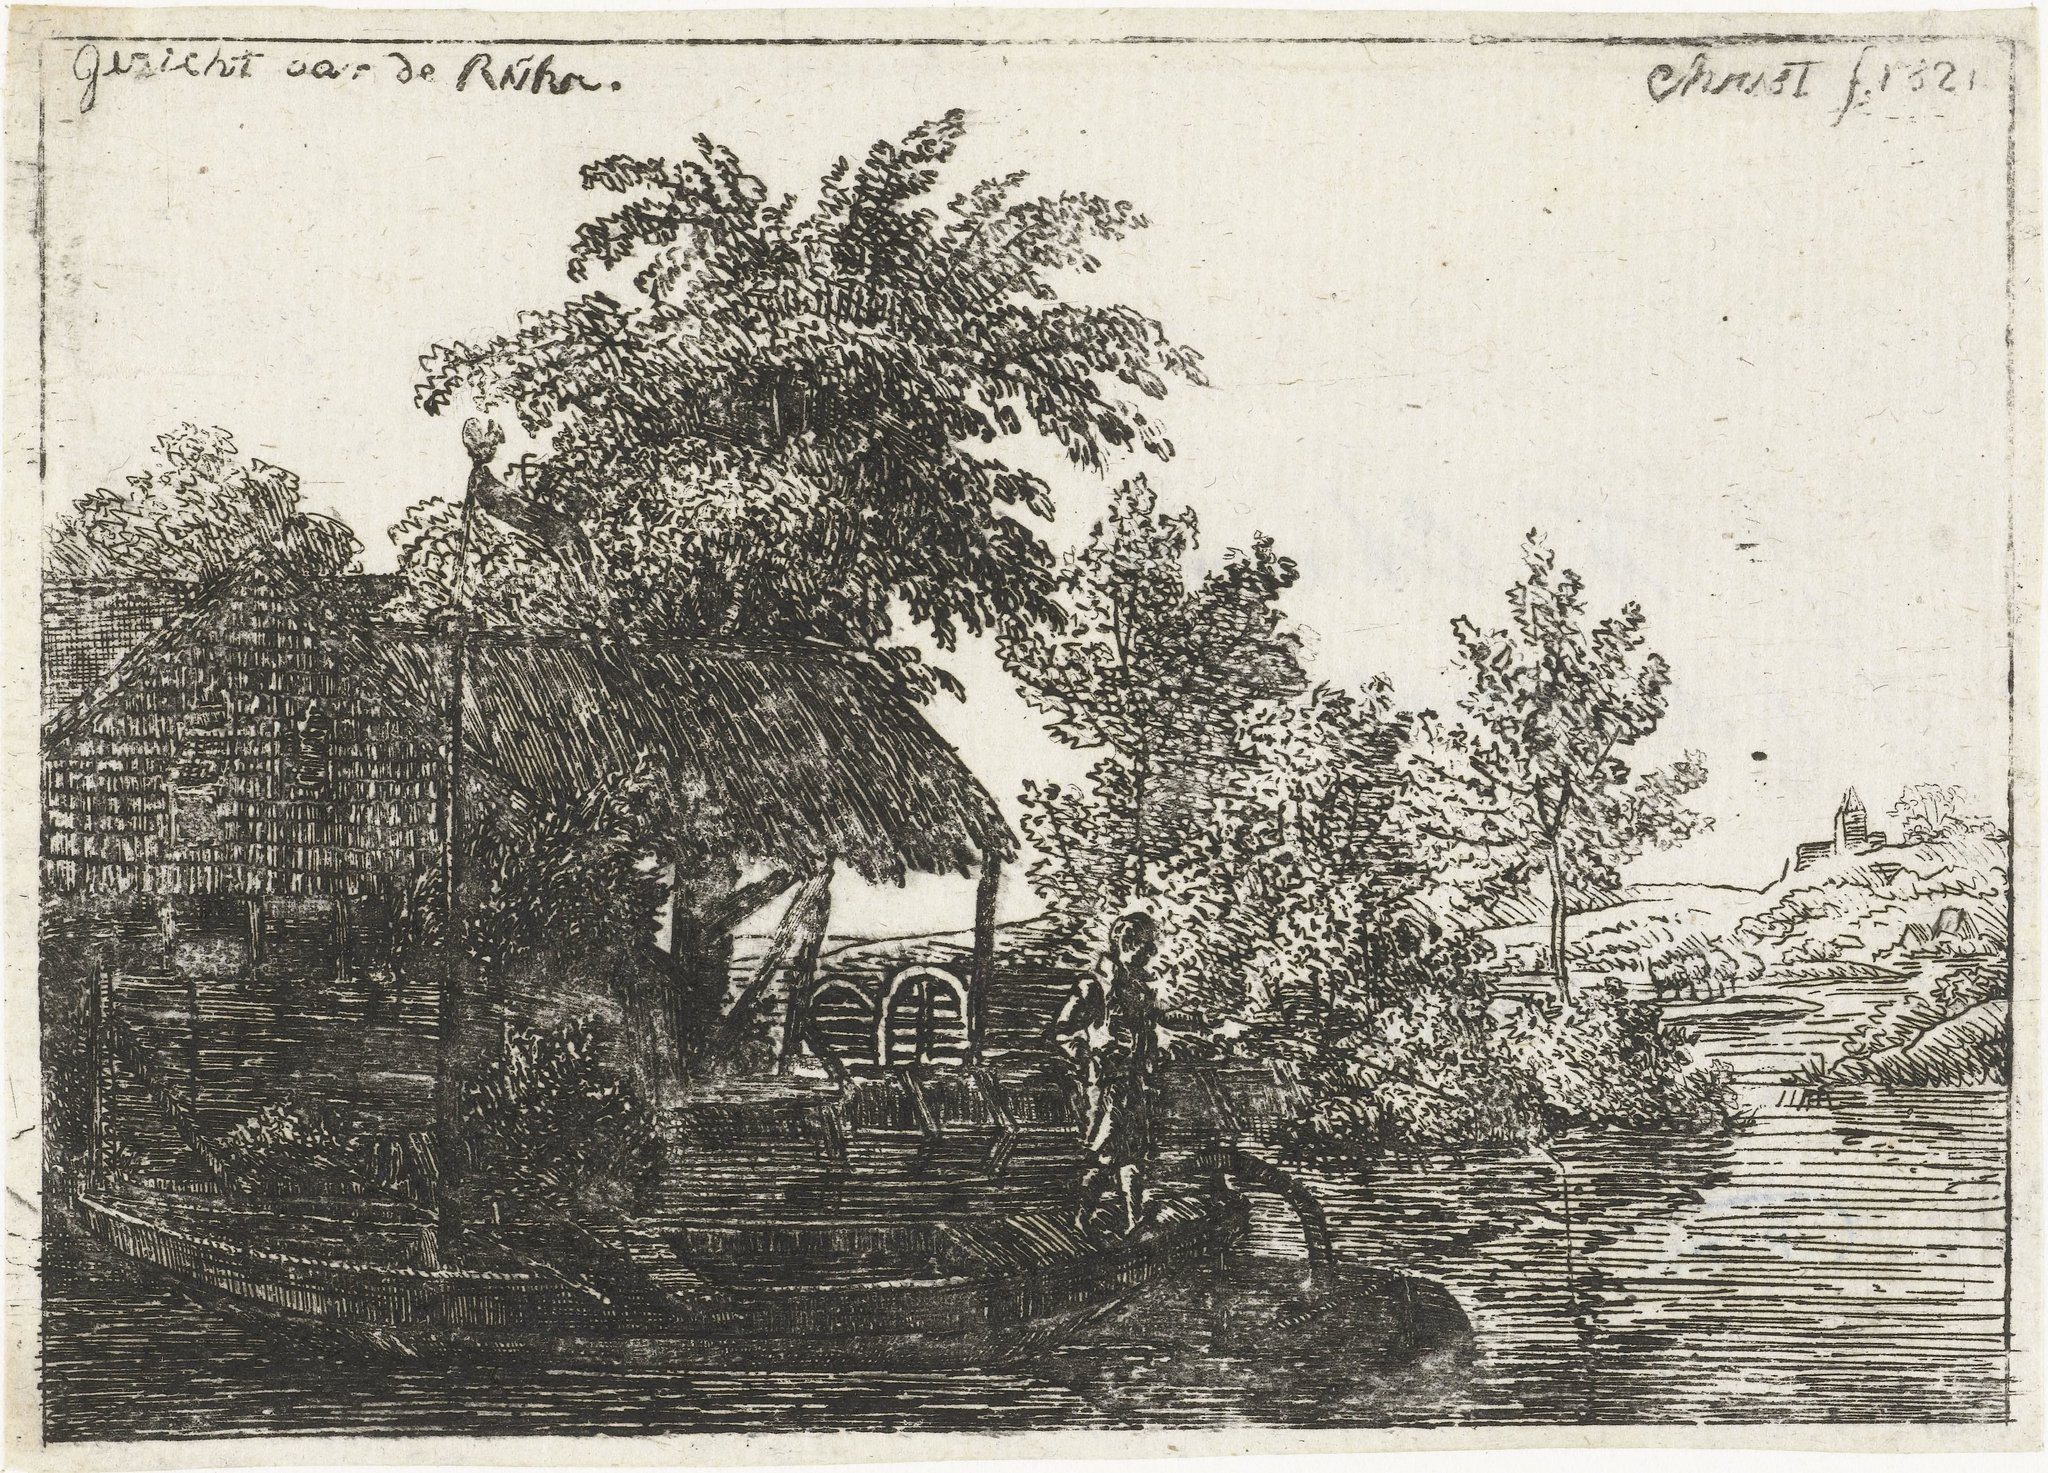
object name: print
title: Gezicht aan de Ruhr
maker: johannes franciscus christ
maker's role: draughtsman, print maker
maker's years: 1790-1845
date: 1821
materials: paper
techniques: etching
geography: nijmegen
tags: river (+ landscape with figures, staffage)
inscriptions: collector's mark: Lugt 2228